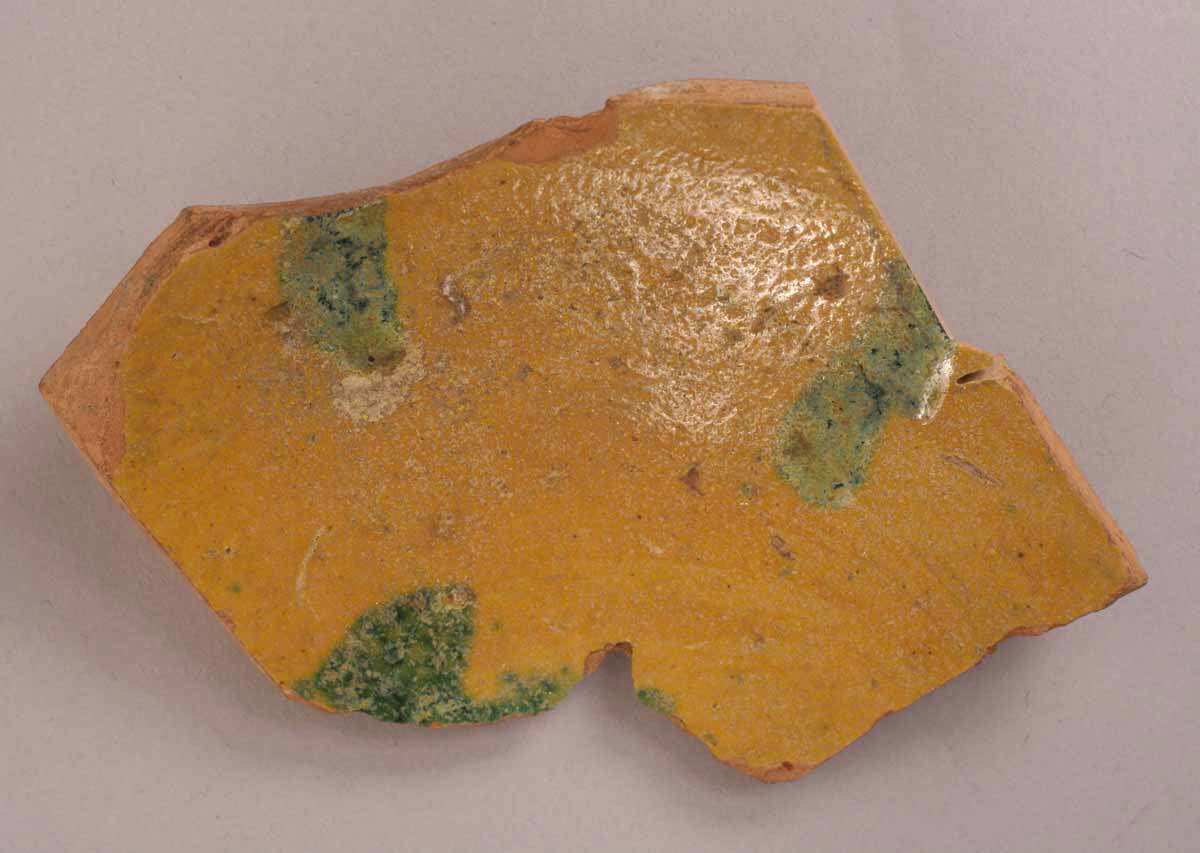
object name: fragment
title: Ceramic Fragment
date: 701-900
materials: earthenware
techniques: glazing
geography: iraq